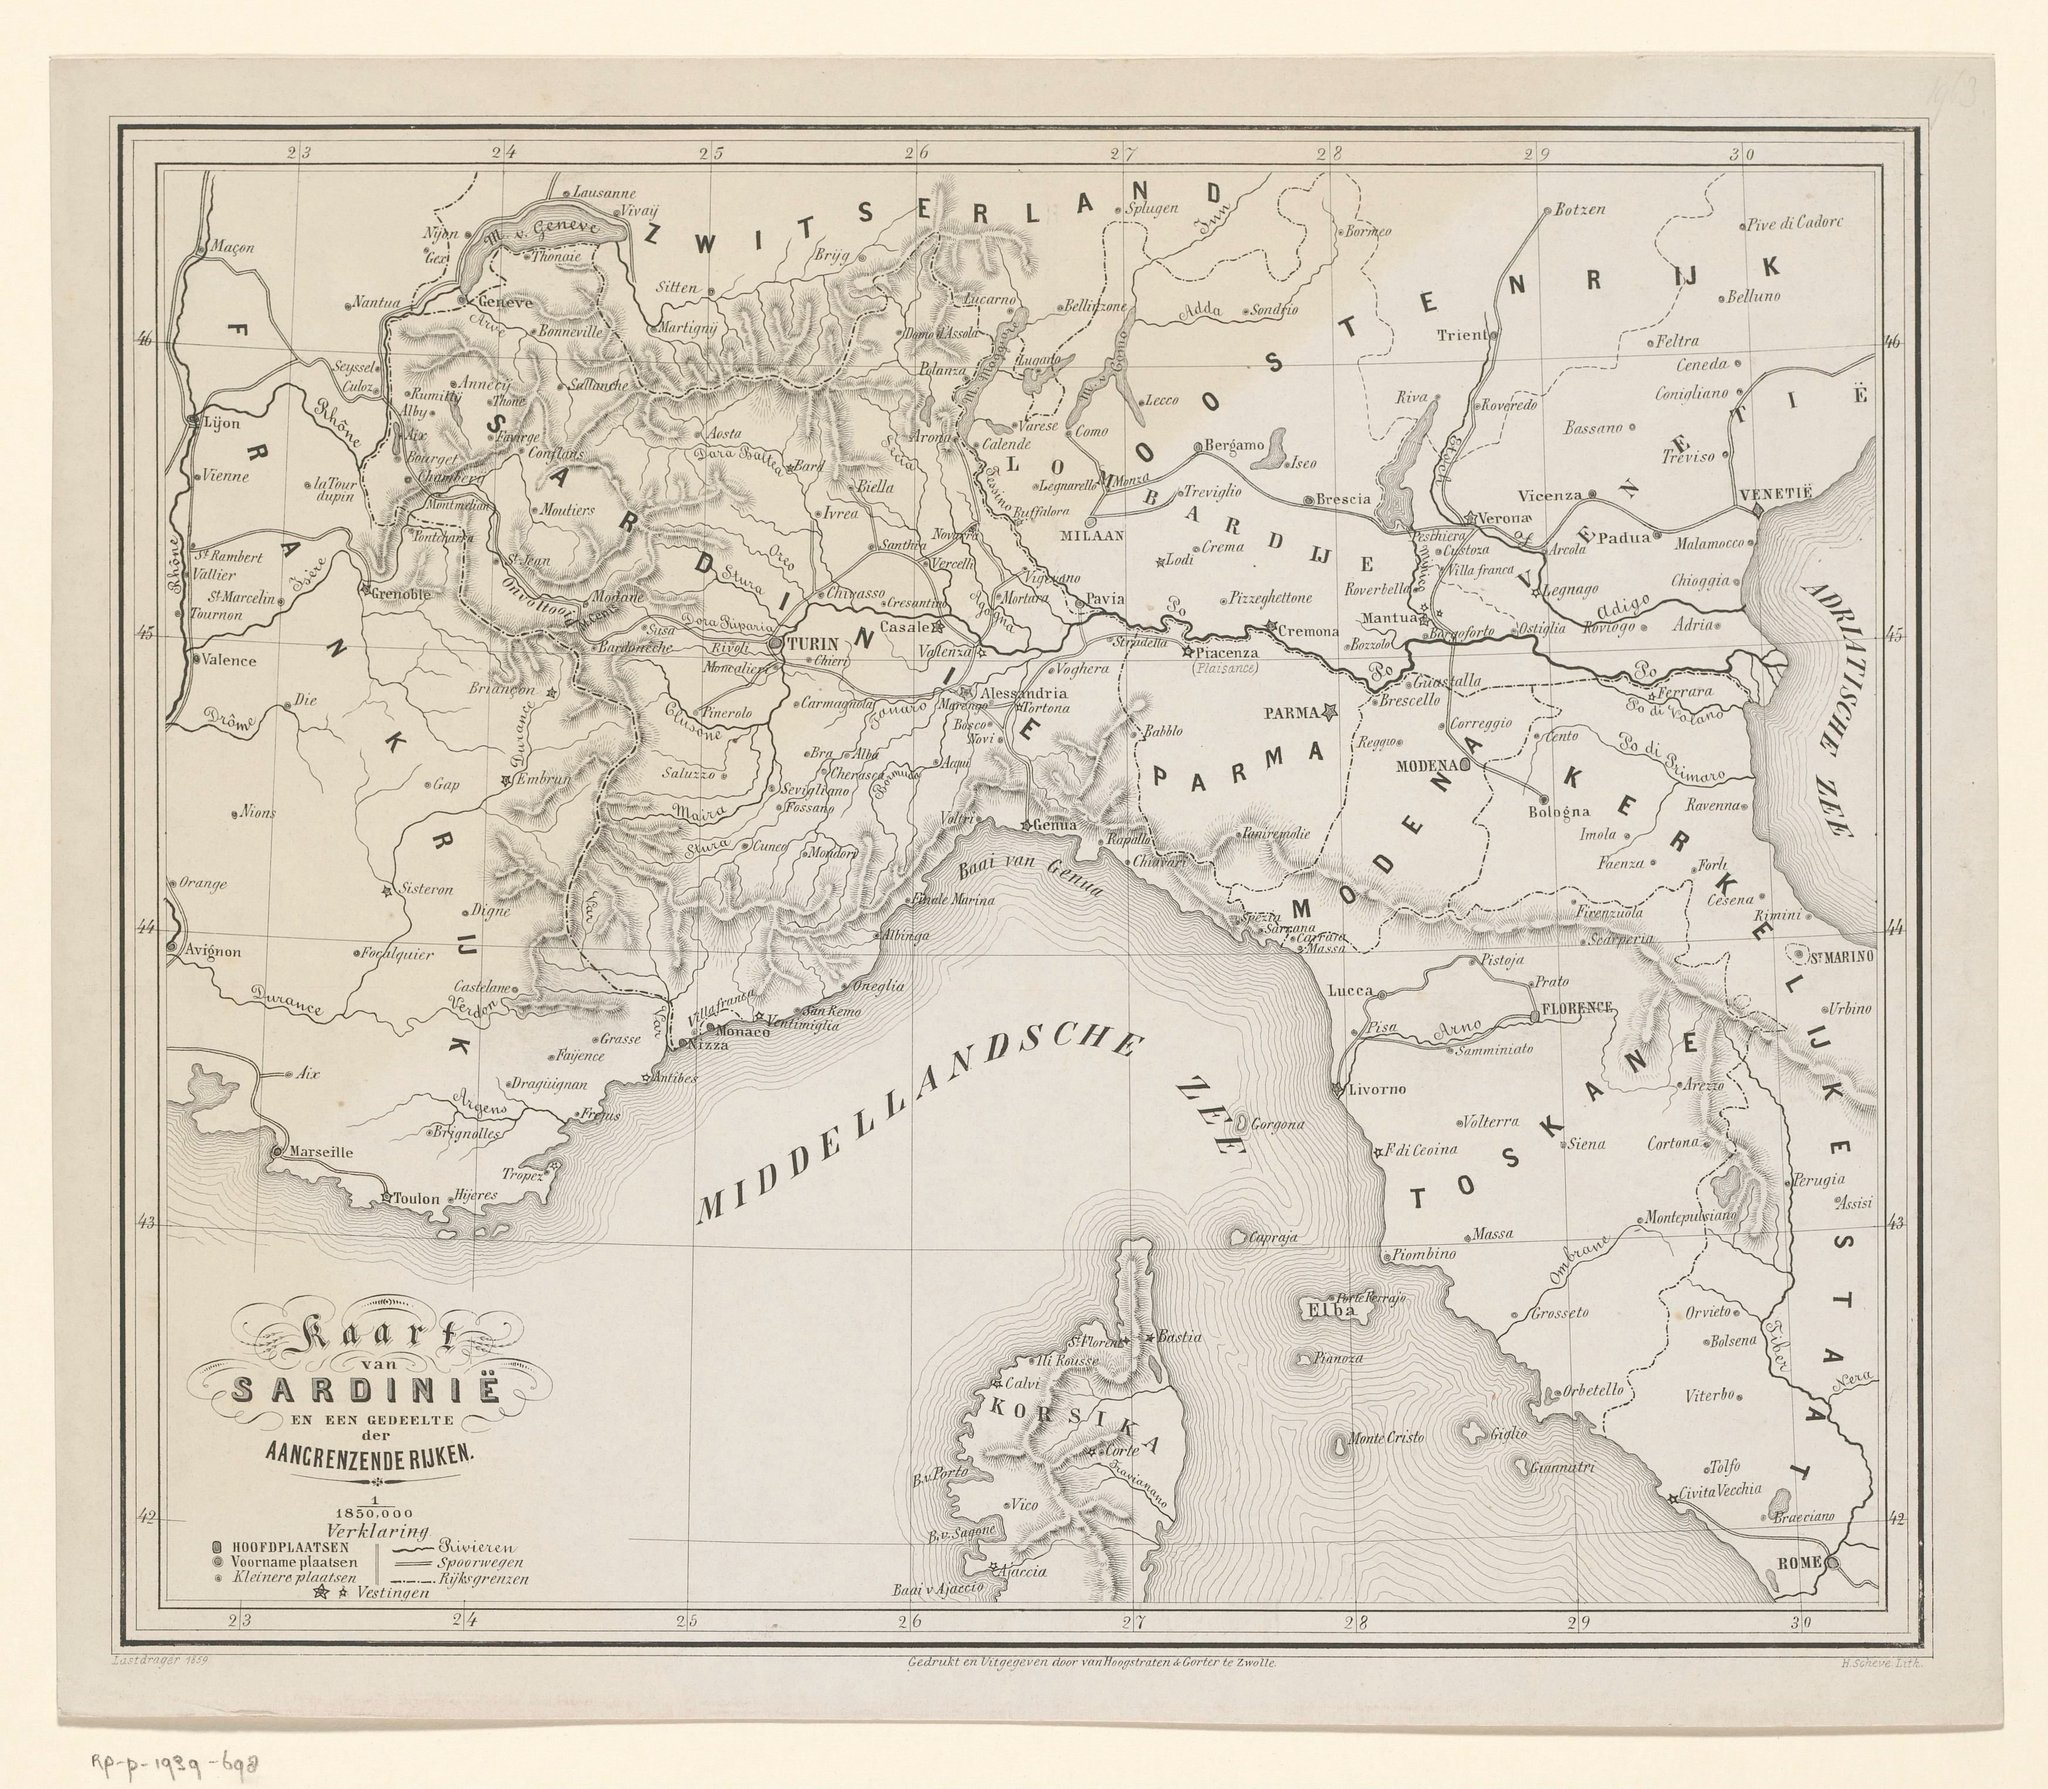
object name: map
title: Kaart van Sardinië en een gedeelte der aangrenzende rijken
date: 1859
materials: paper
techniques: lithograph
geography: zwolle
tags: maps of separate countries or regions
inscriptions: collector's mark: Lugt 2760, collector's mark: Lugt 2166